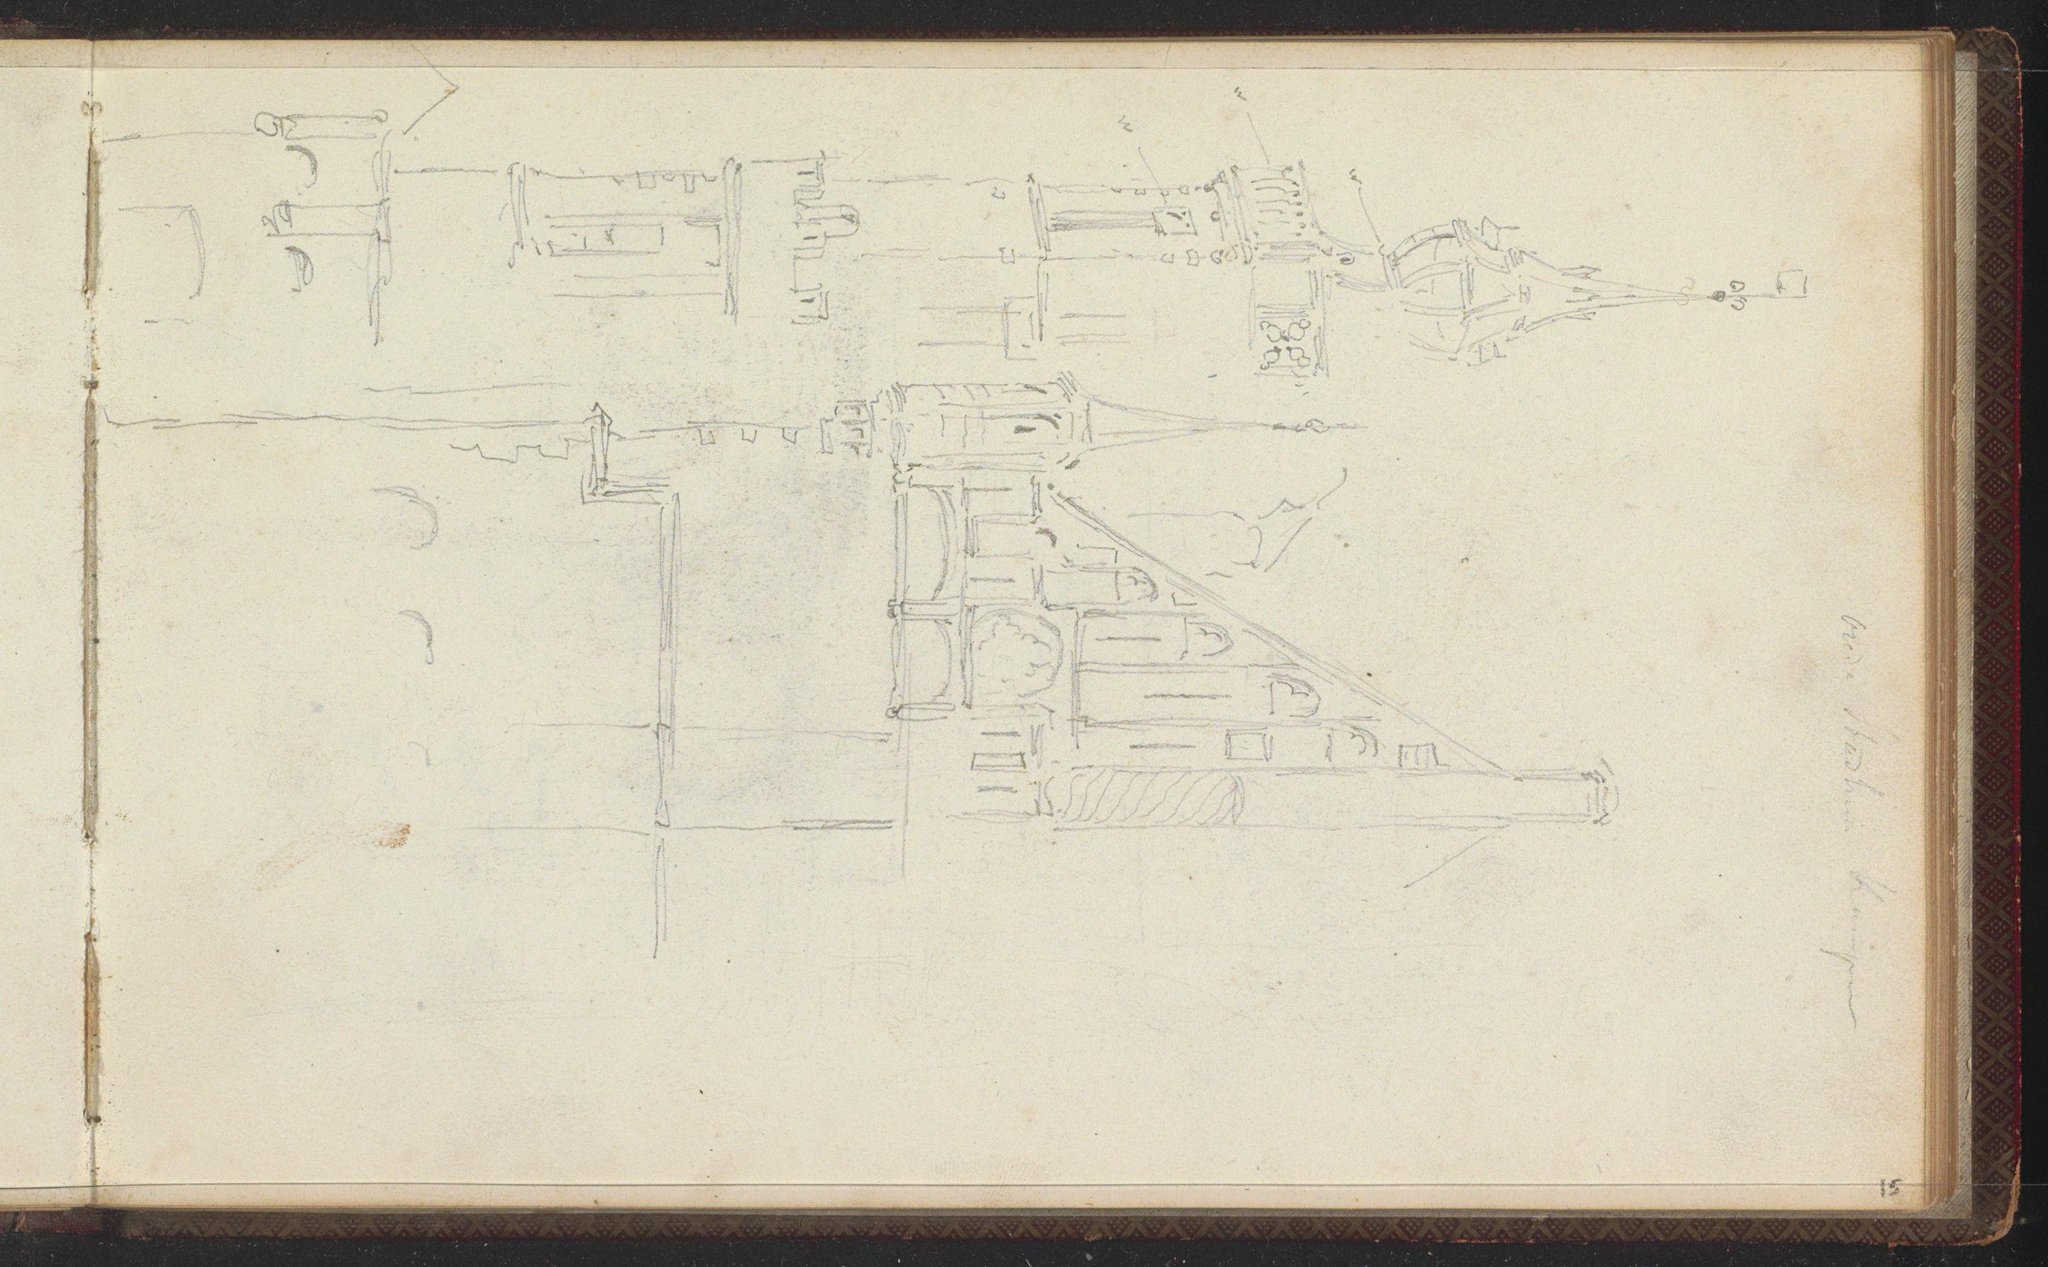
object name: sketchbook leaf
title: Stadhuis te Kampen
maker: adrianus eversen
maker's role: draughtsman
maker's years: 1818-1897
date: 1828-1897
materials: paper, pencil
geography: kampen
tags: townhall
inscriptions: annotation: ‘Oude Stadhuis Kampen’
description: Studie van het stadhuis te Kampen. Blad 15 recto uit een schetsboek met 52 bladen vervaardigd in de omgeving van Kampen, Hattem, Hoorn en Zwolle.